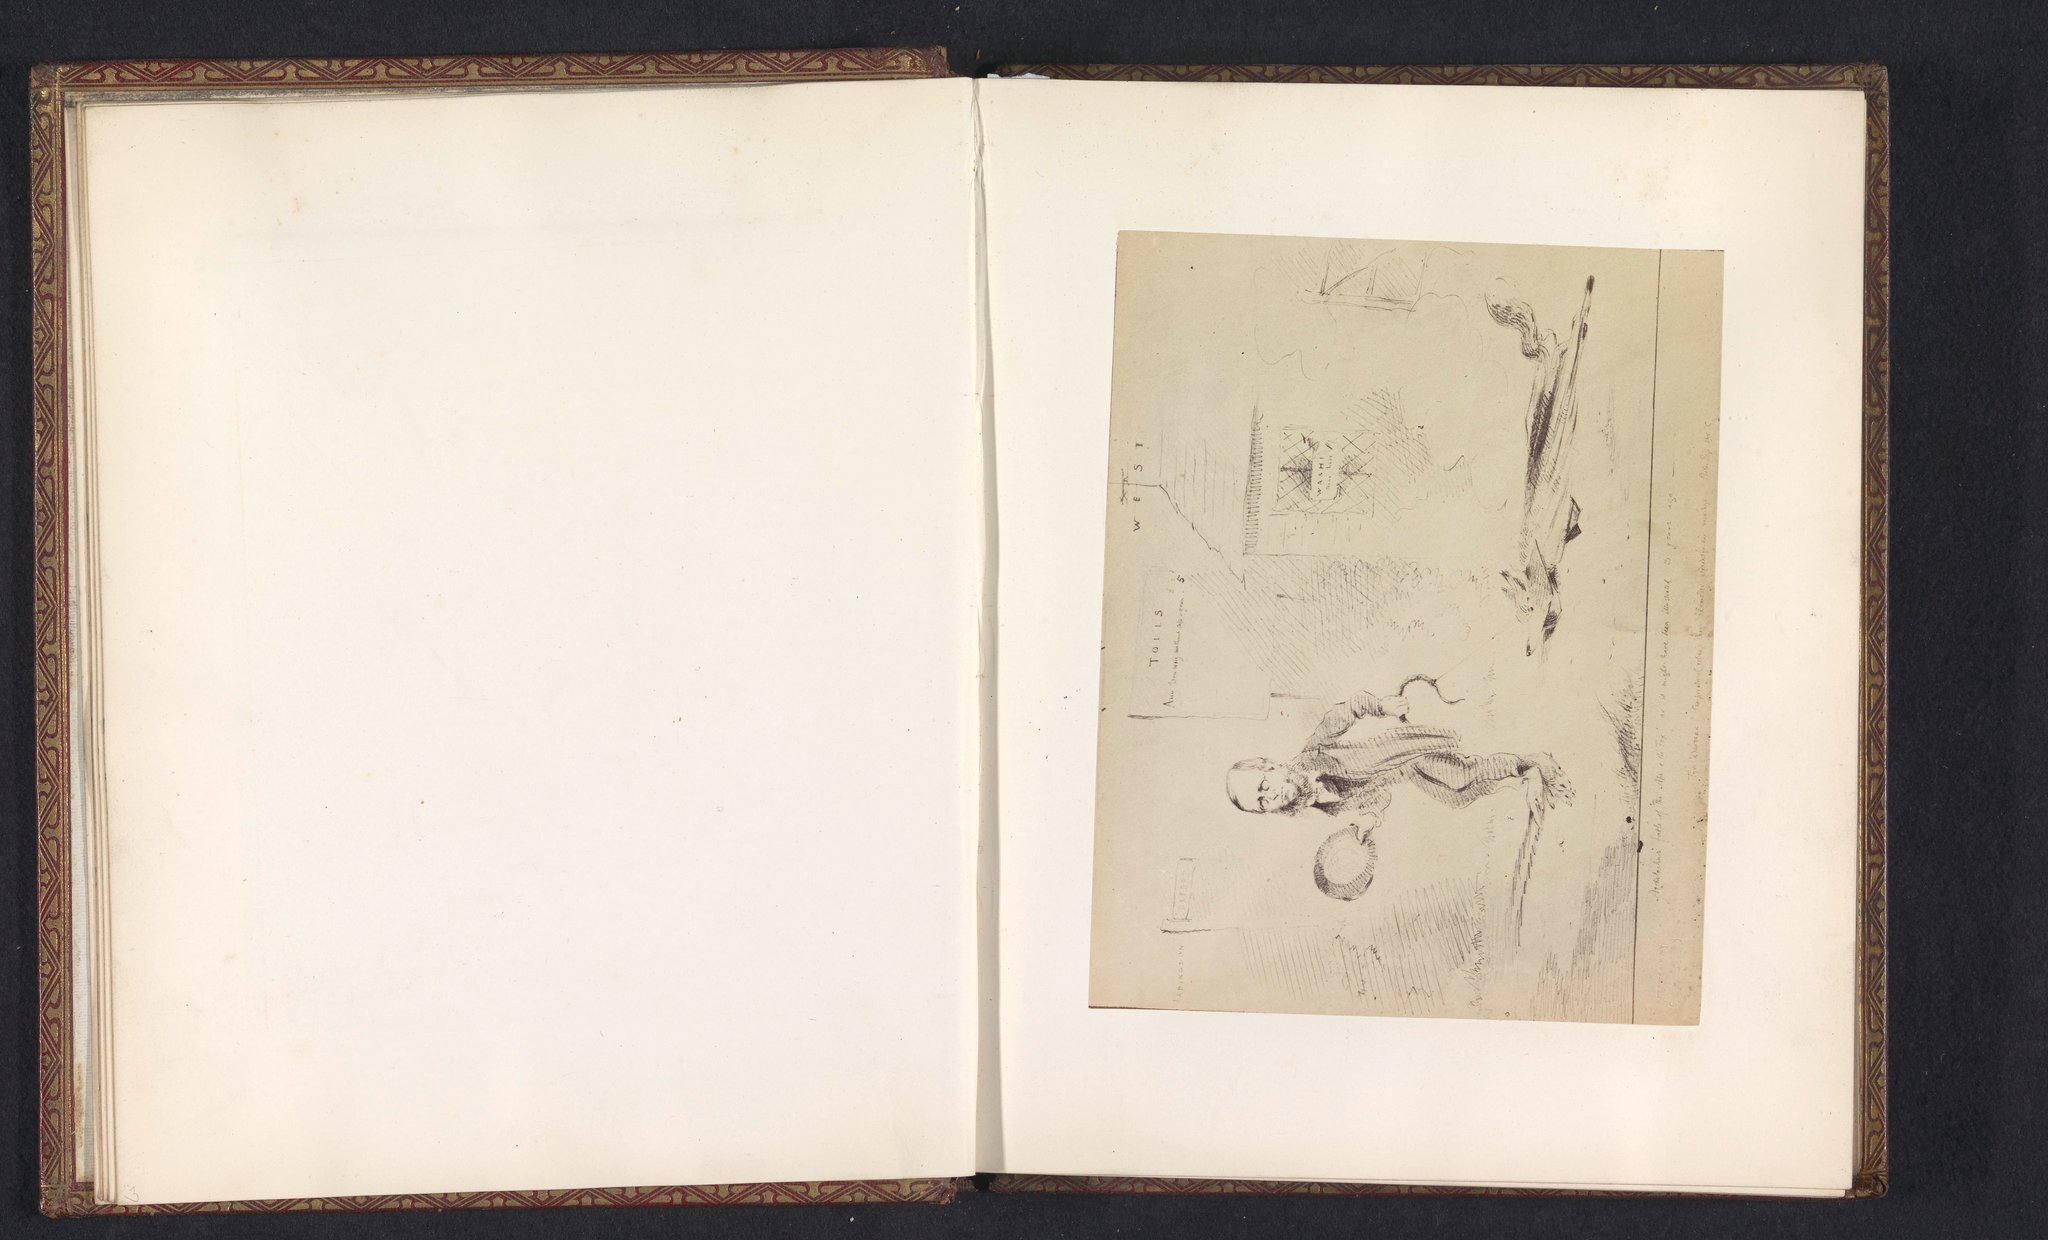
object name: photograph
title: Fotoreproductie van een tekening, voorstellende de geestelijke Washbourne West als een aap trekt een vos voort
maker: Anonymous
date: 1855-1866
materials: photographic support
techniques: albumen print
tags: monkeys, apes, caricatures (human types), student life, beasts of prey, predatory animals: fox